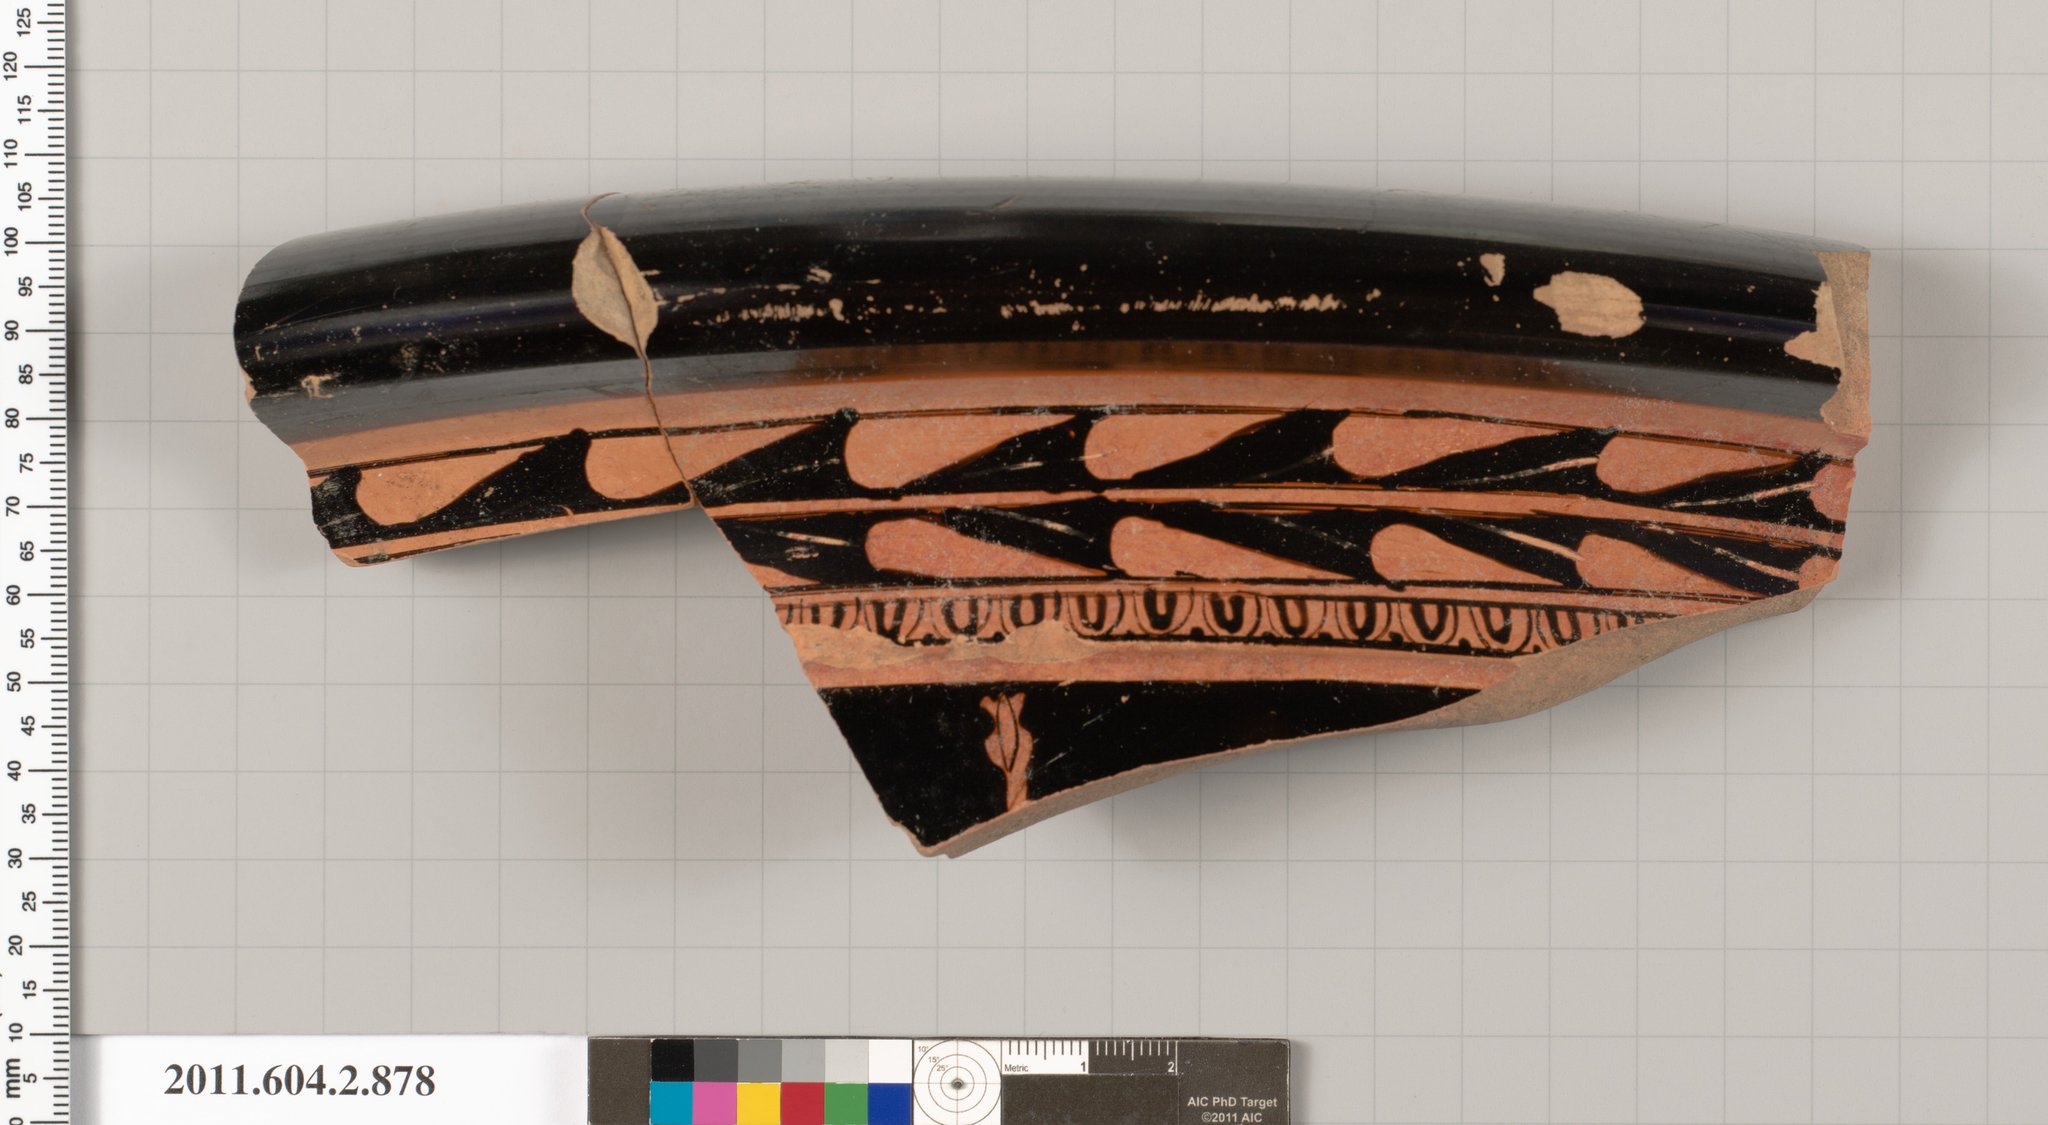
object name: bell krater fragment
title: Terracotta fragment of a bell-krater (bowl for mixing wine and water)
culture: greek, attic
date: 460-450 BCE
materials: terracotta